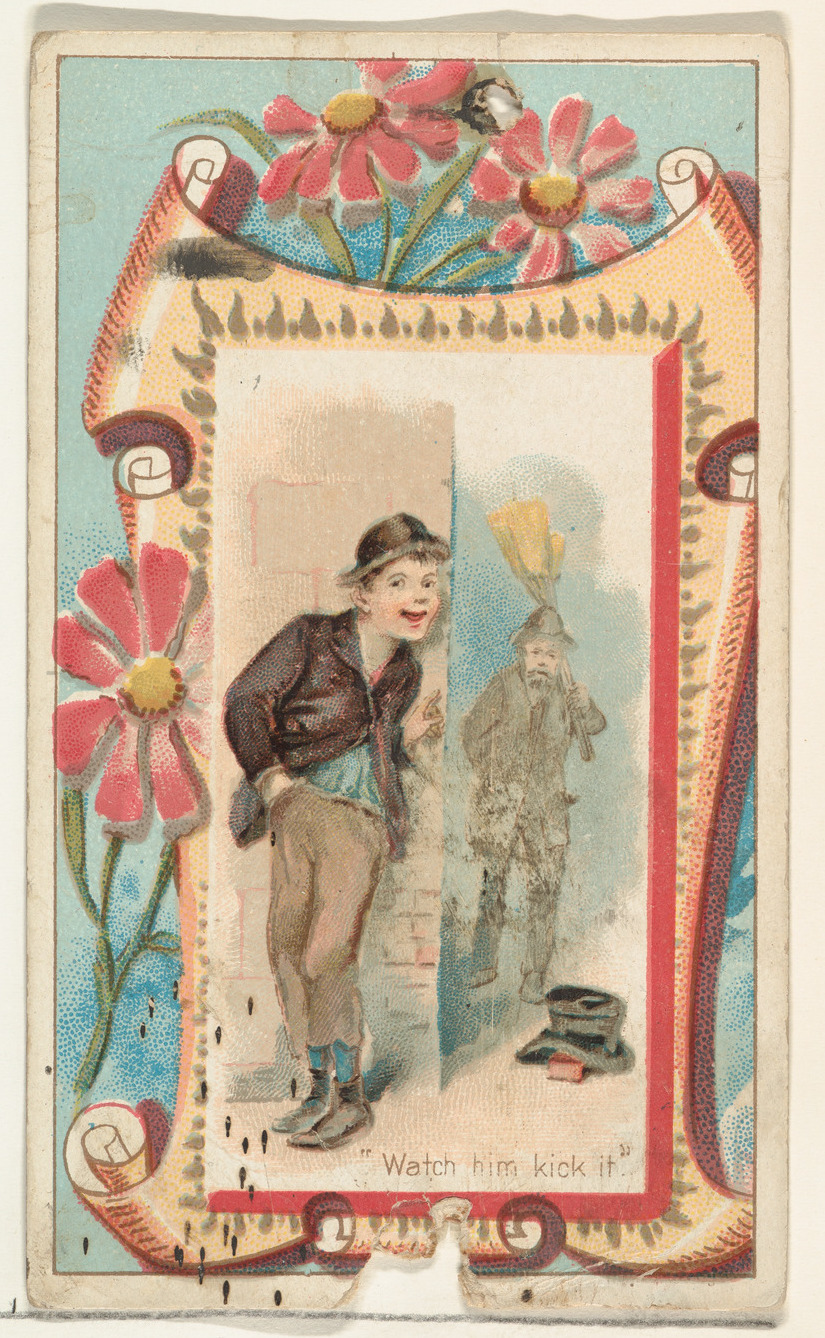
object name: print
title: "Watch him kick it," from the Terrors of America set (N136) issued by Duke Sons & Co. to promote Honest Long Cut Tobacco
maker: w. duke, sons & co.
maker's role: publisher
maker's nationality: american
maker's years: 1870-1920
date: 1888-1889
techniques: color lithograph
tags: boys,men,flowers